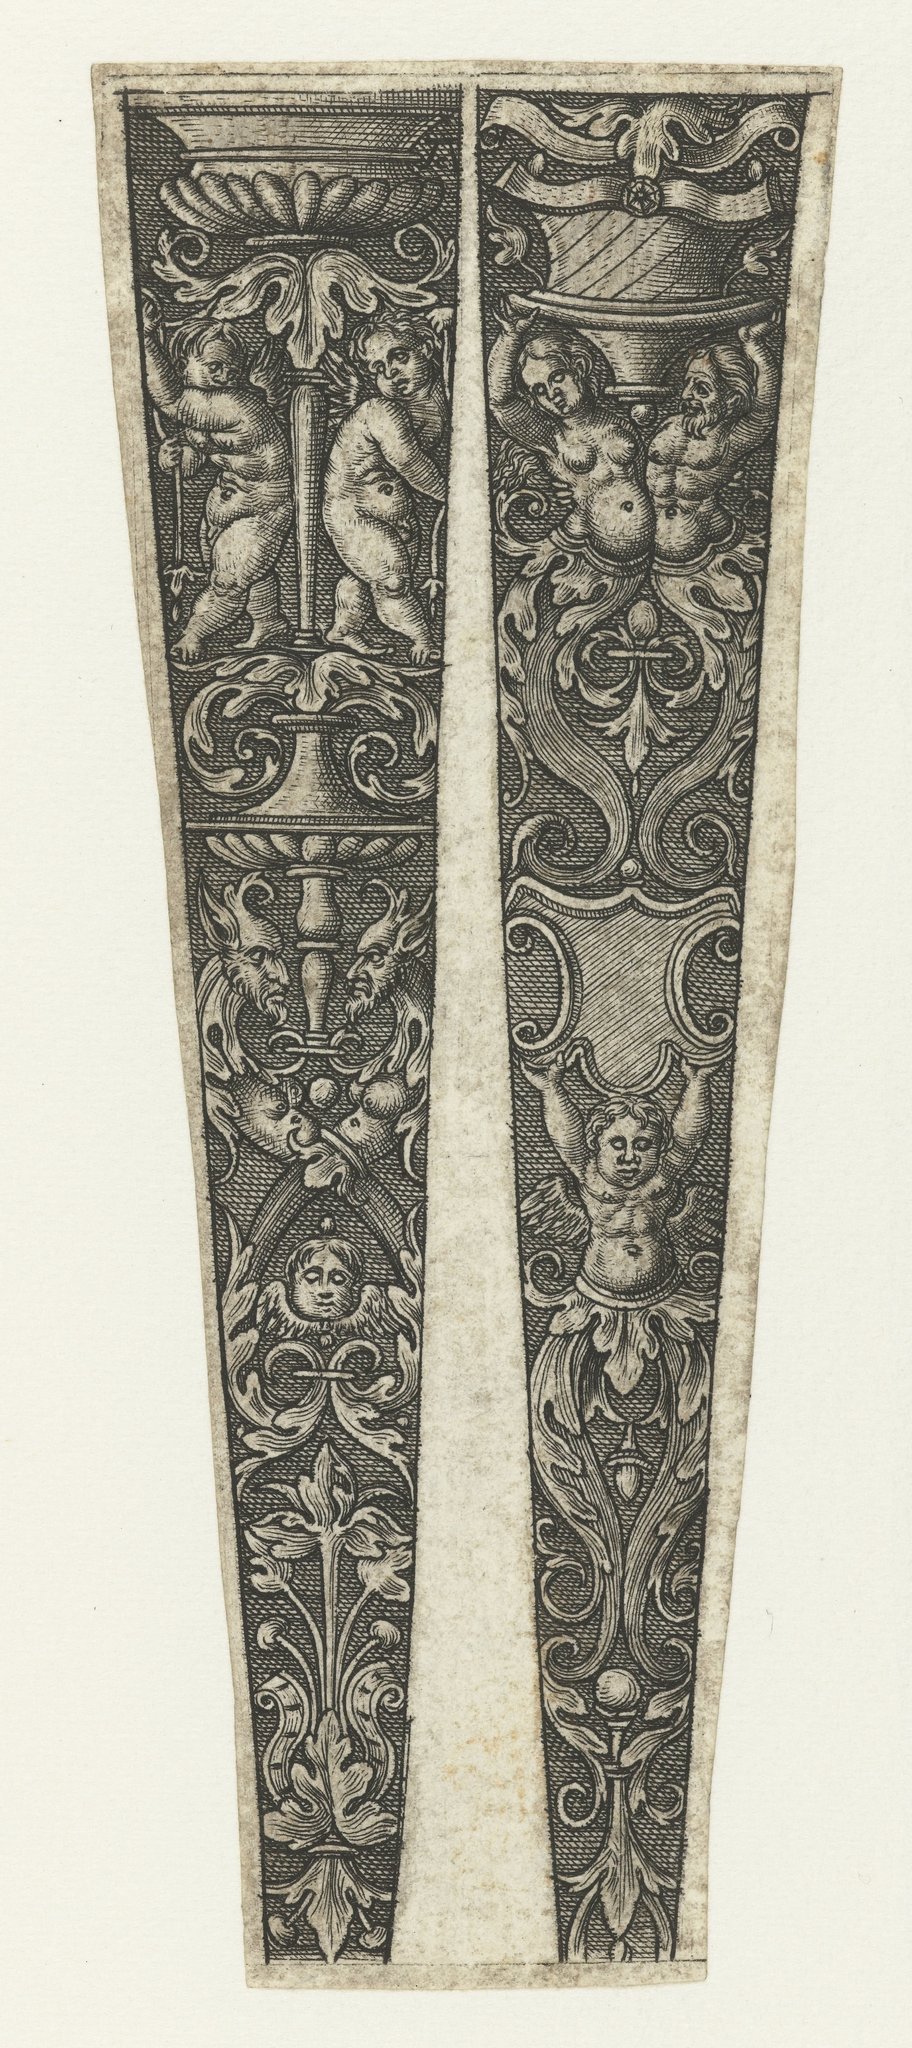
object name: ornament print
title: Twee ornamenten met putti en bladranken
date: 1520-1562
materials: paper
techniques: engraving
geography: low countries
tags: cupids: 'amores', 'amoretti', 'putti'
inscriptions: collector's mark: Lugt 2773, collector's mark: Lugt 2228, collector's mark: Lugt 2773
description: Ontwerp voor voor- en achterzijde dolkschede op één blad. Links: bladranken met twee putti. Rechts: putti en man en vrouw met onderlichaam van bladranken.